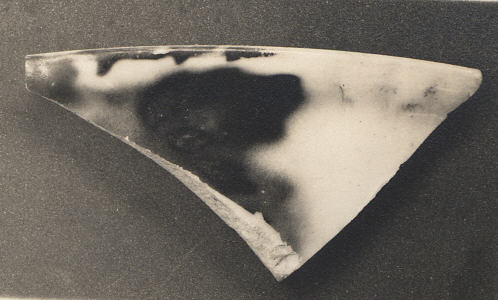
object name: fragment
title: Fragment of a Bowl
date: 801-1000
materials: porcelain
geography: china